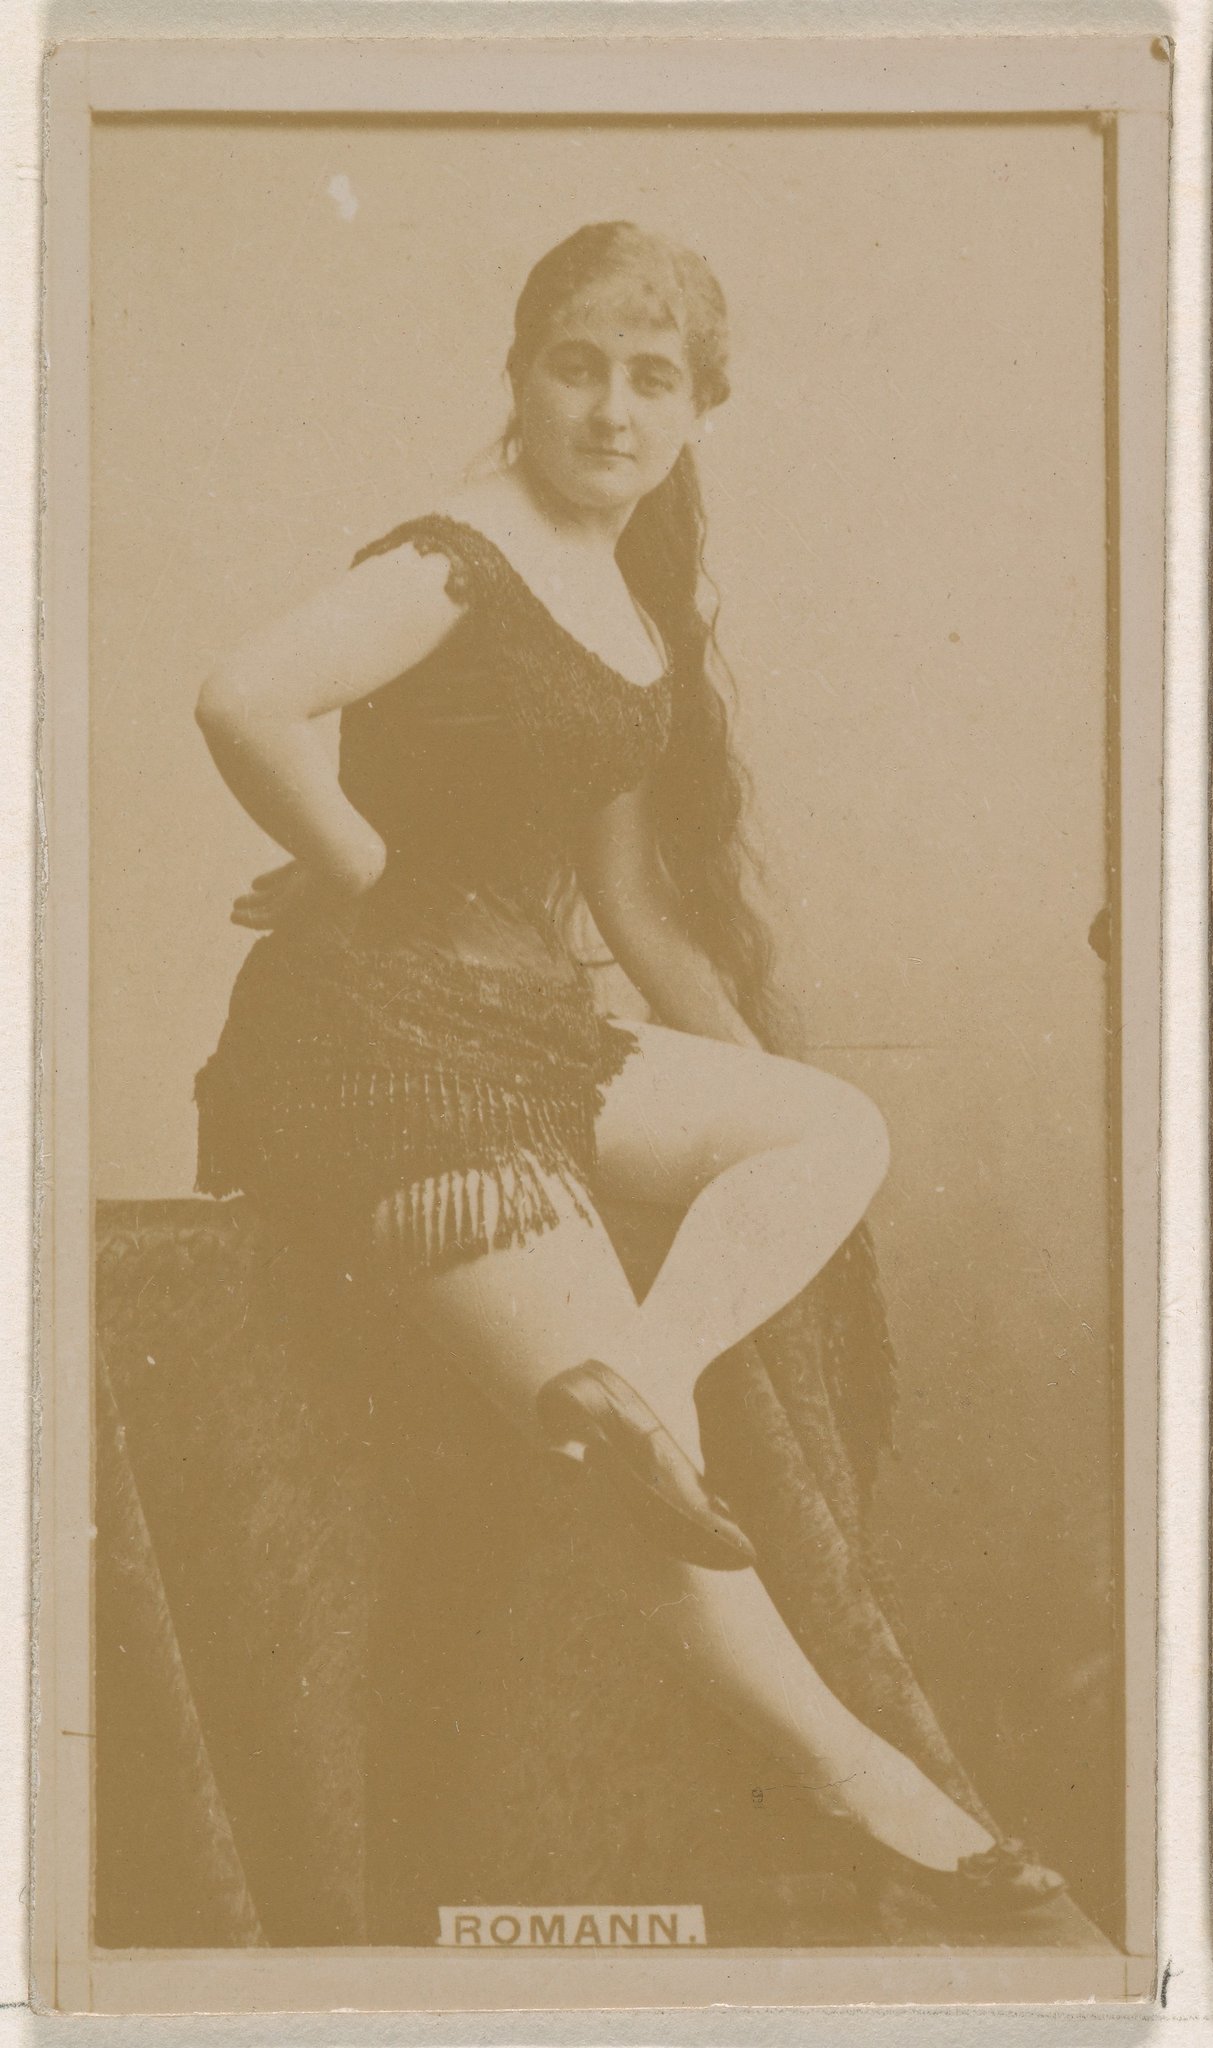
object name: photograph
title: Miss Romann, from the Actresses series (N245) issued by Kinney Brothers to promote Sweet Caporal Cigarettes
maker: kinney brothers tobacco company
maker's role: publisher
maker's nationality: american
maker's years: 1869-2011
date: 1890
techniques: albumen silver print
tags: portraits,women,actresses